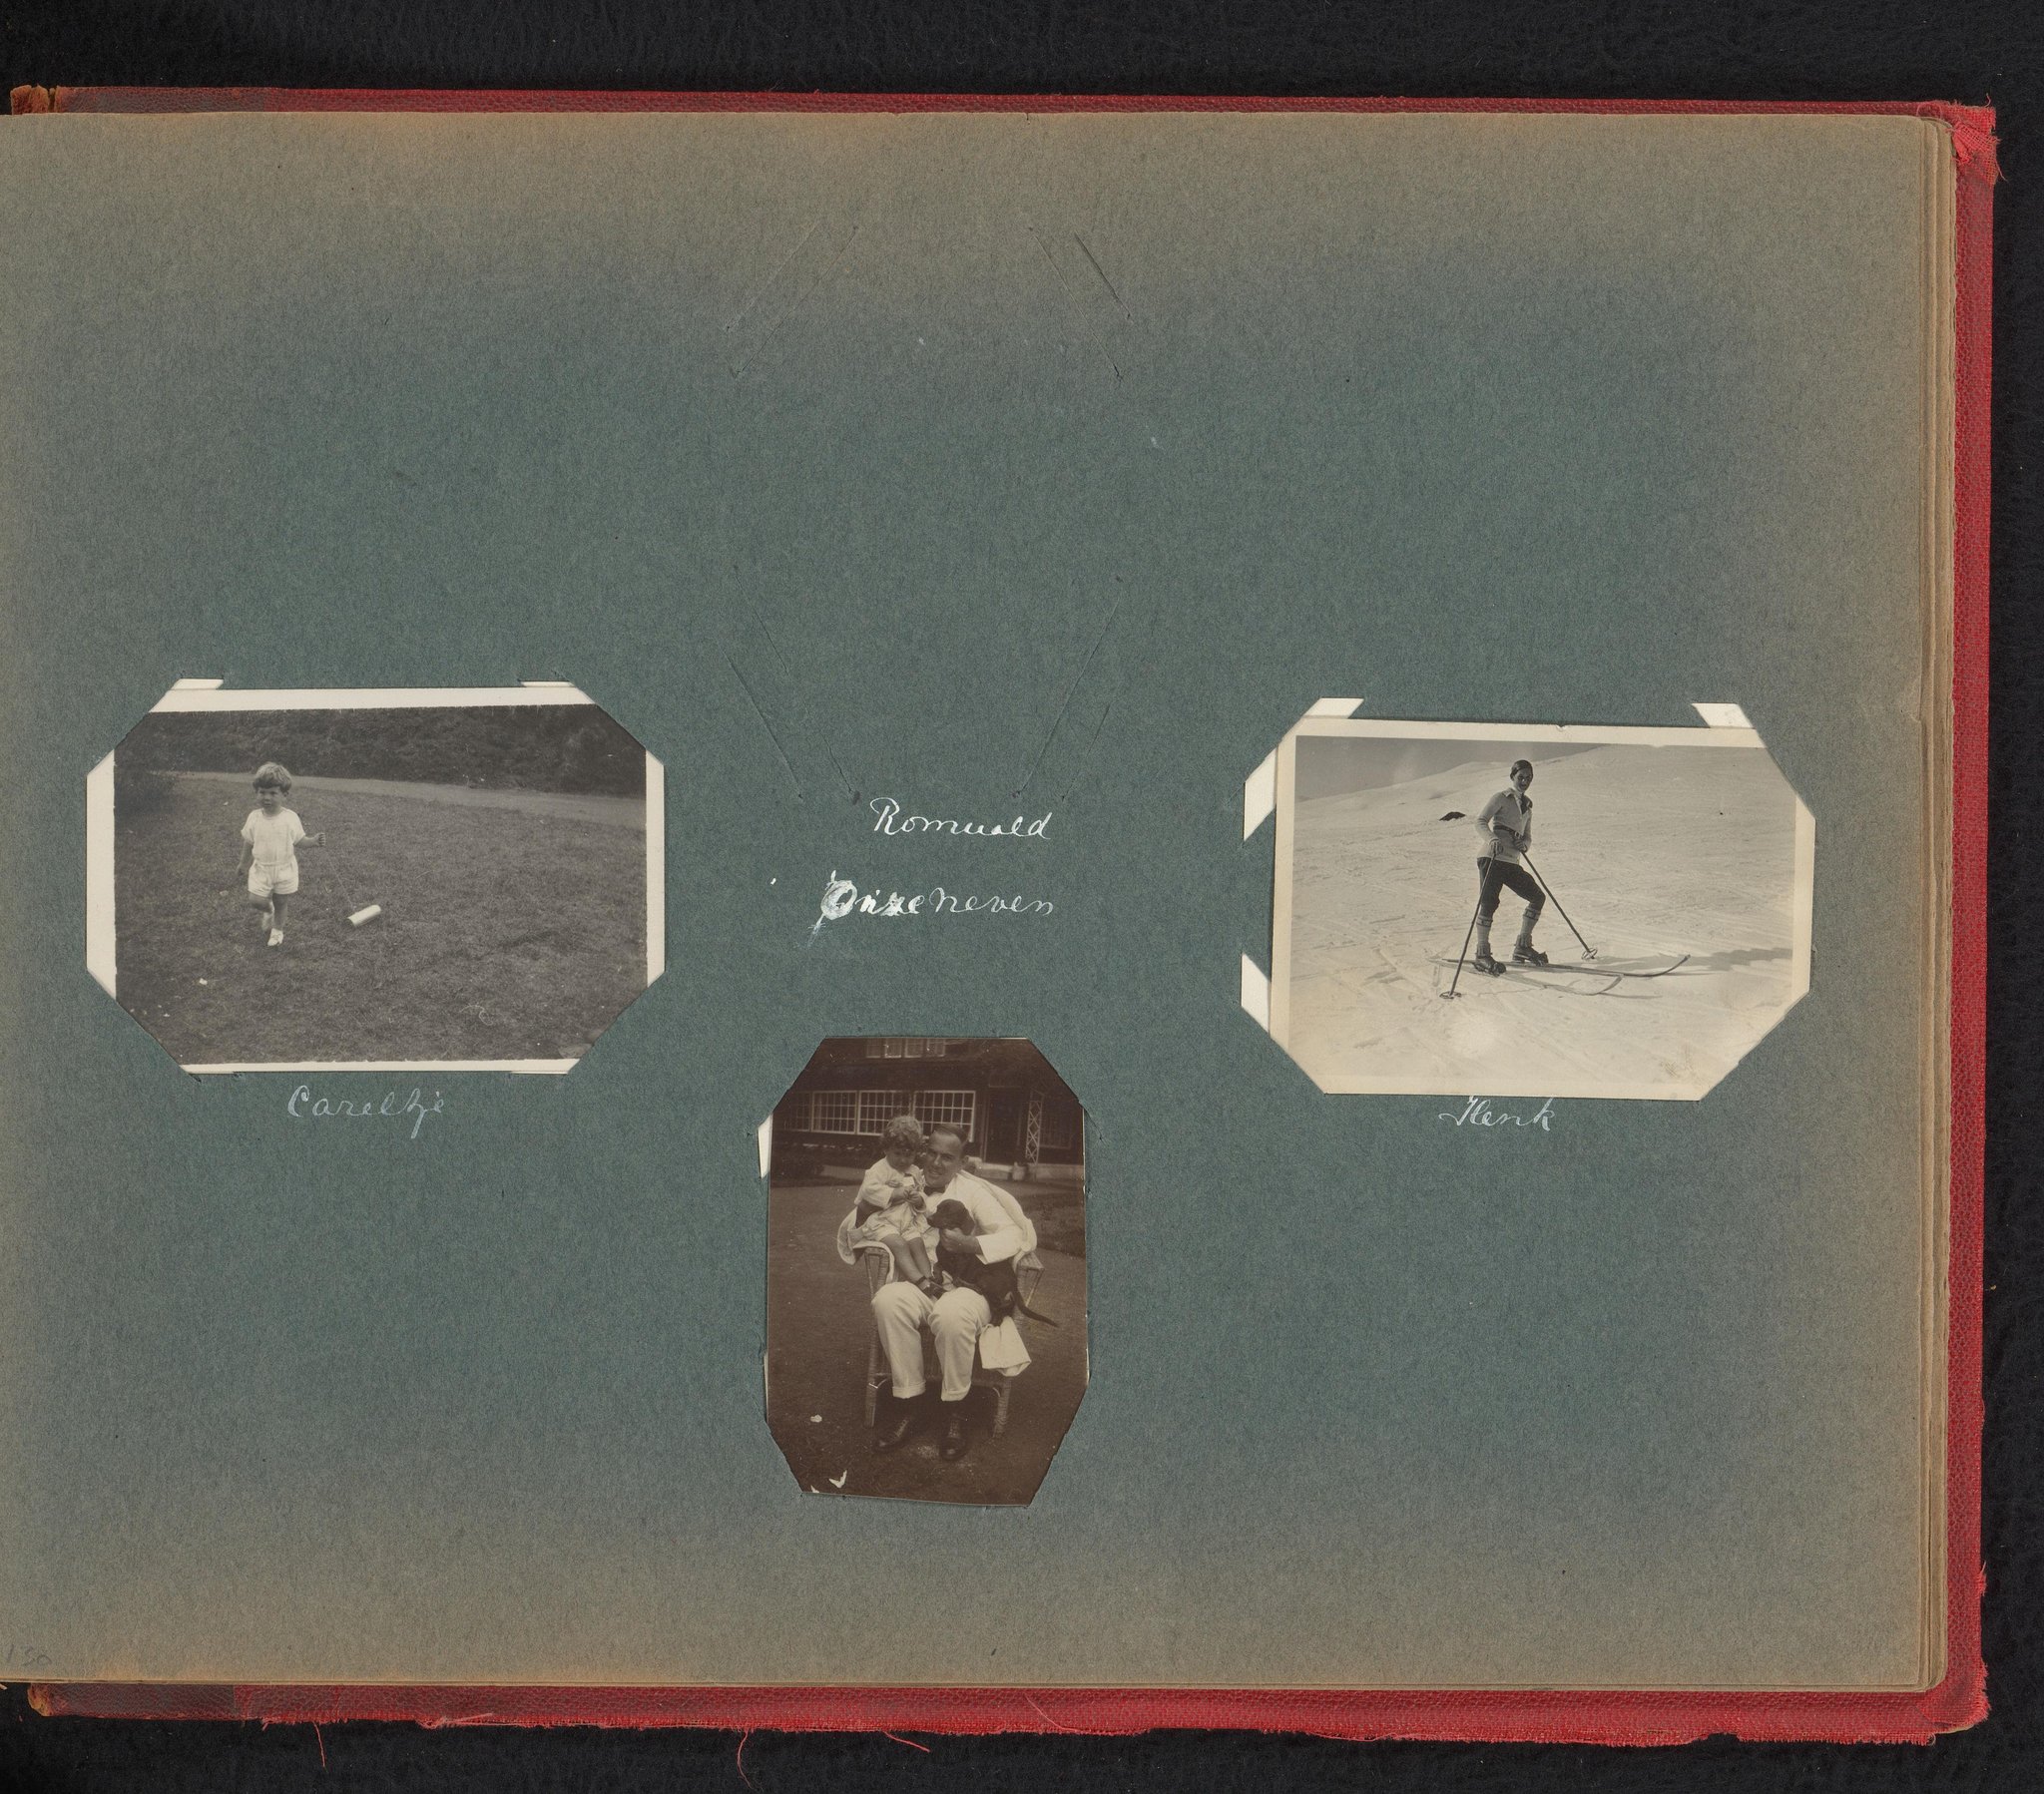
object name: photograph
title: Onze neven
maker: charlotte alida boelen-matthes (lot)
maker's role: amateurfotograaf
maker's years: 1889-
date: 1923-1924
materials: paper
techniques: gelatin silver print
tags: amsterdam, thailand, cousins (third degree family relationships), father and son(s) (family group)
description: Deze foto's zijn onderdeel van een album.